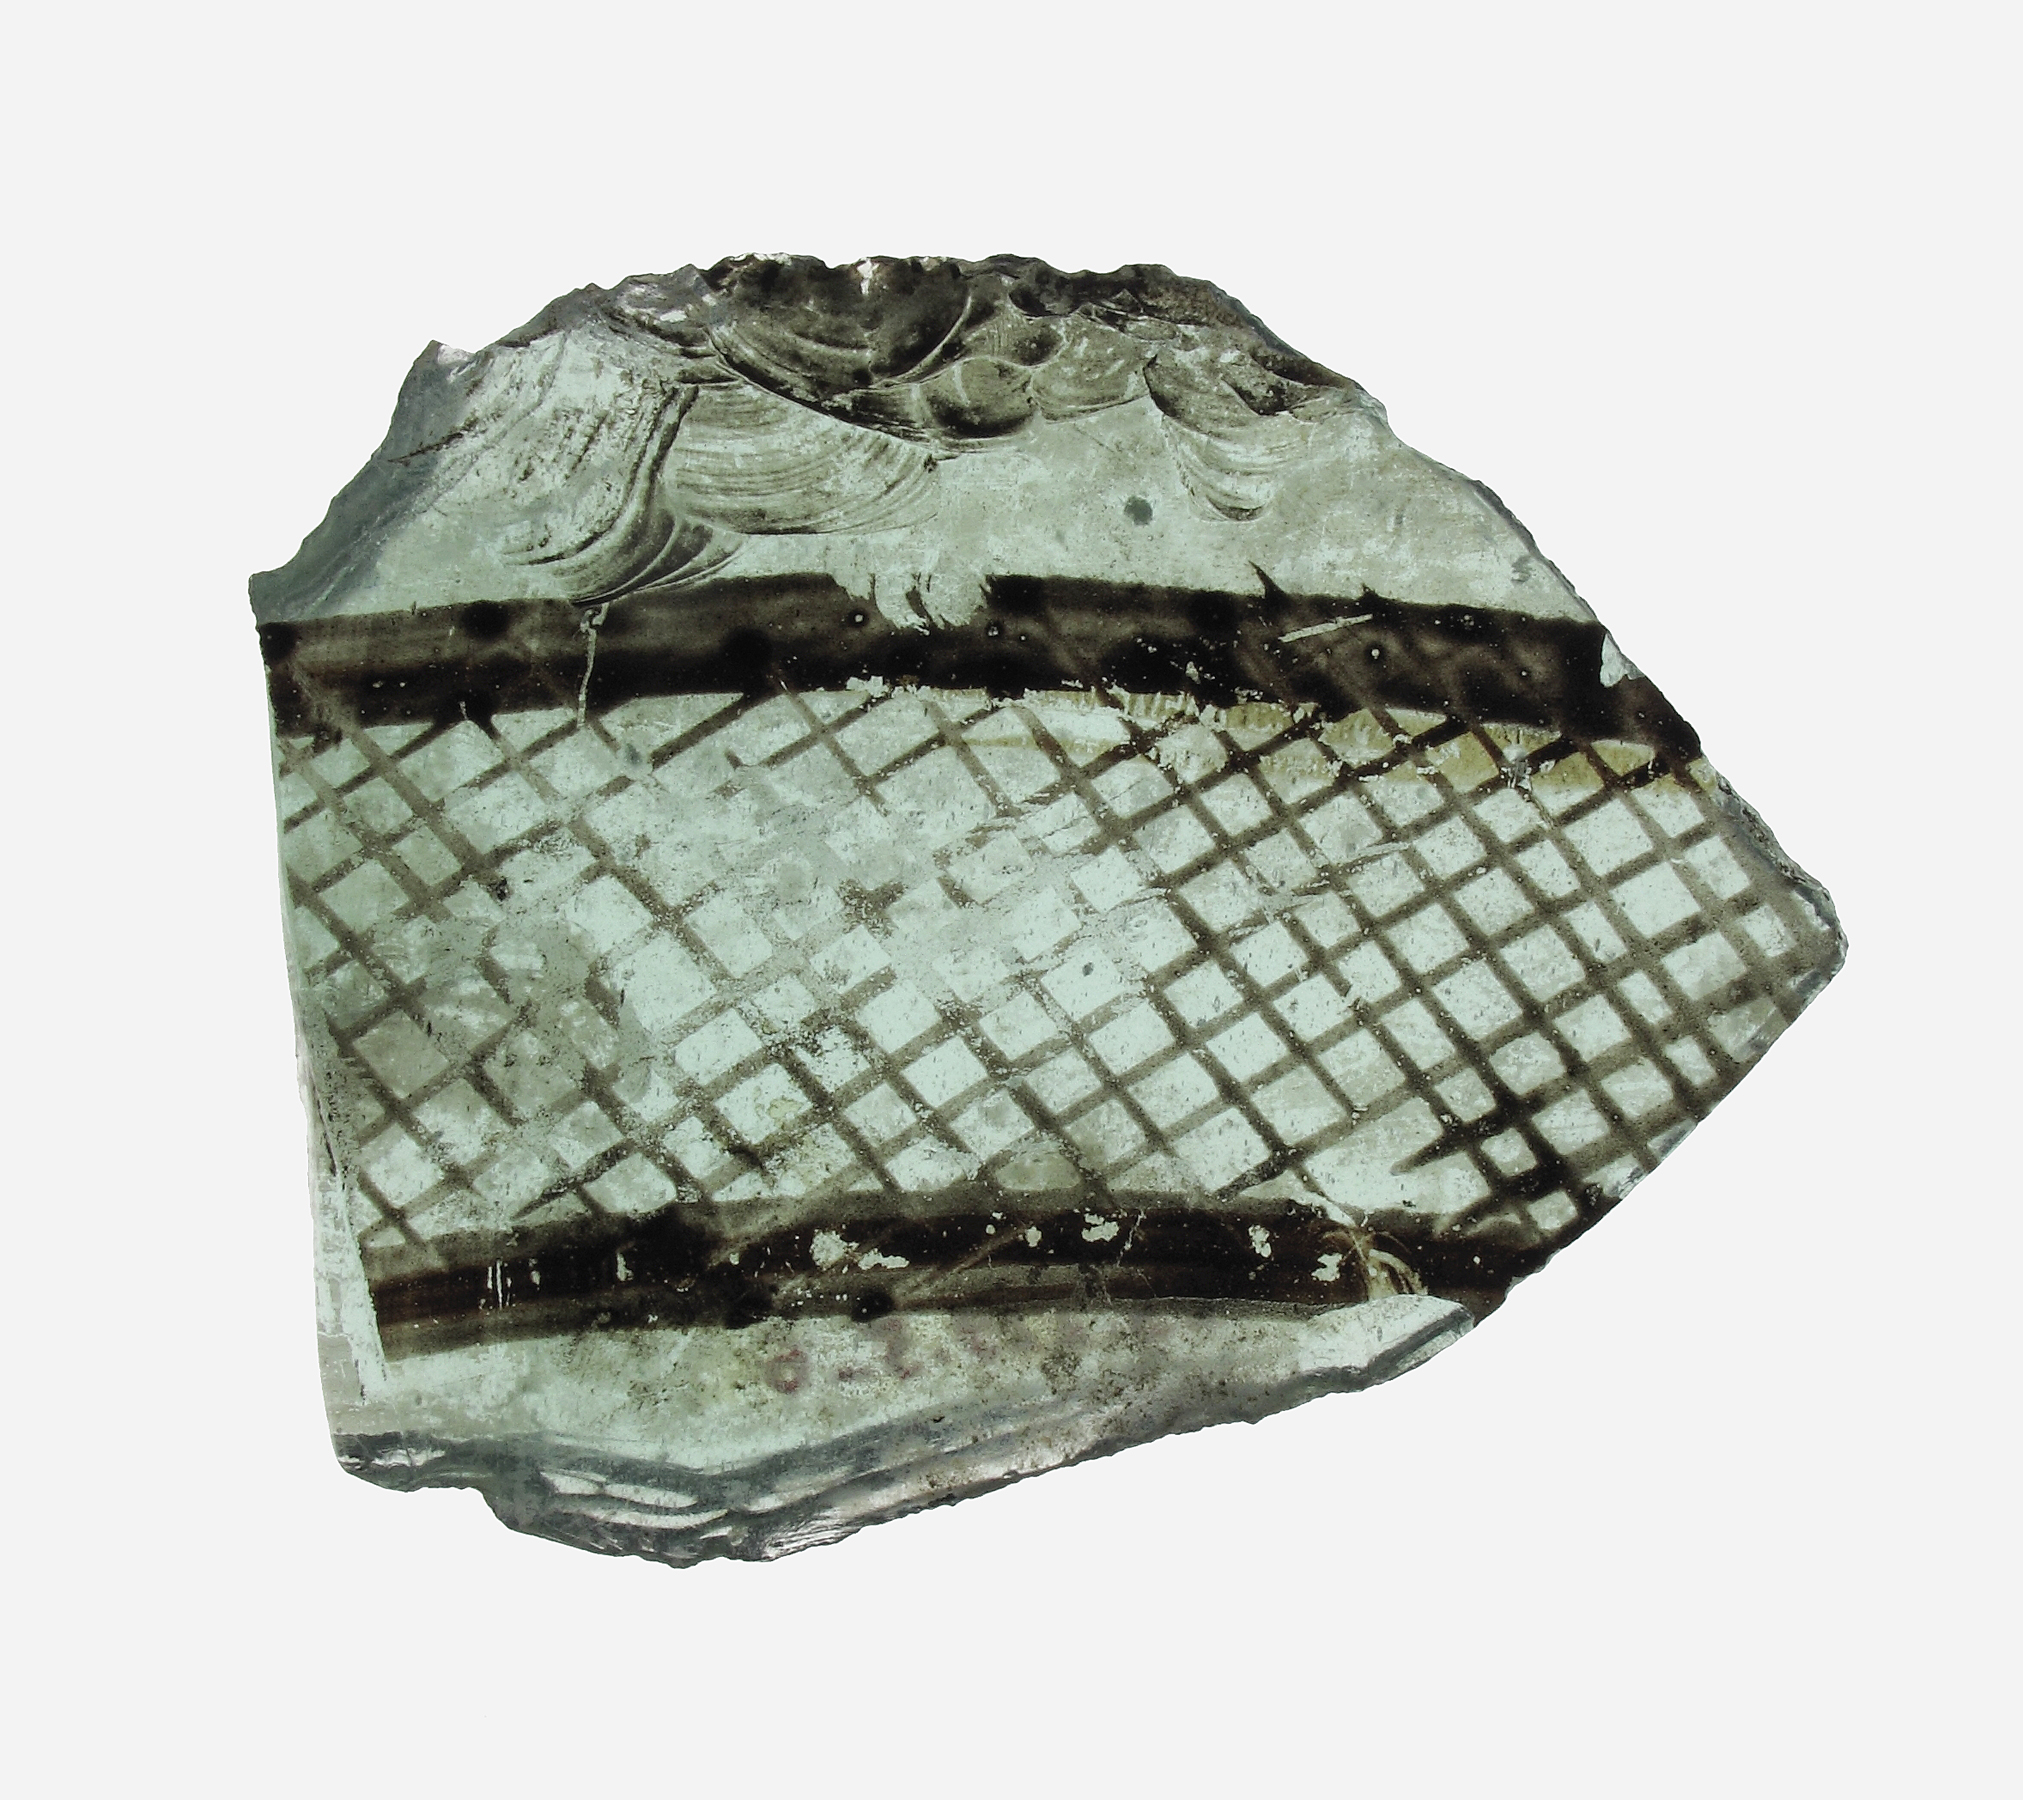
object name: fragment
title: Glass Fragment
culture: french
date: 1201-1300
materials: glass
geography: france